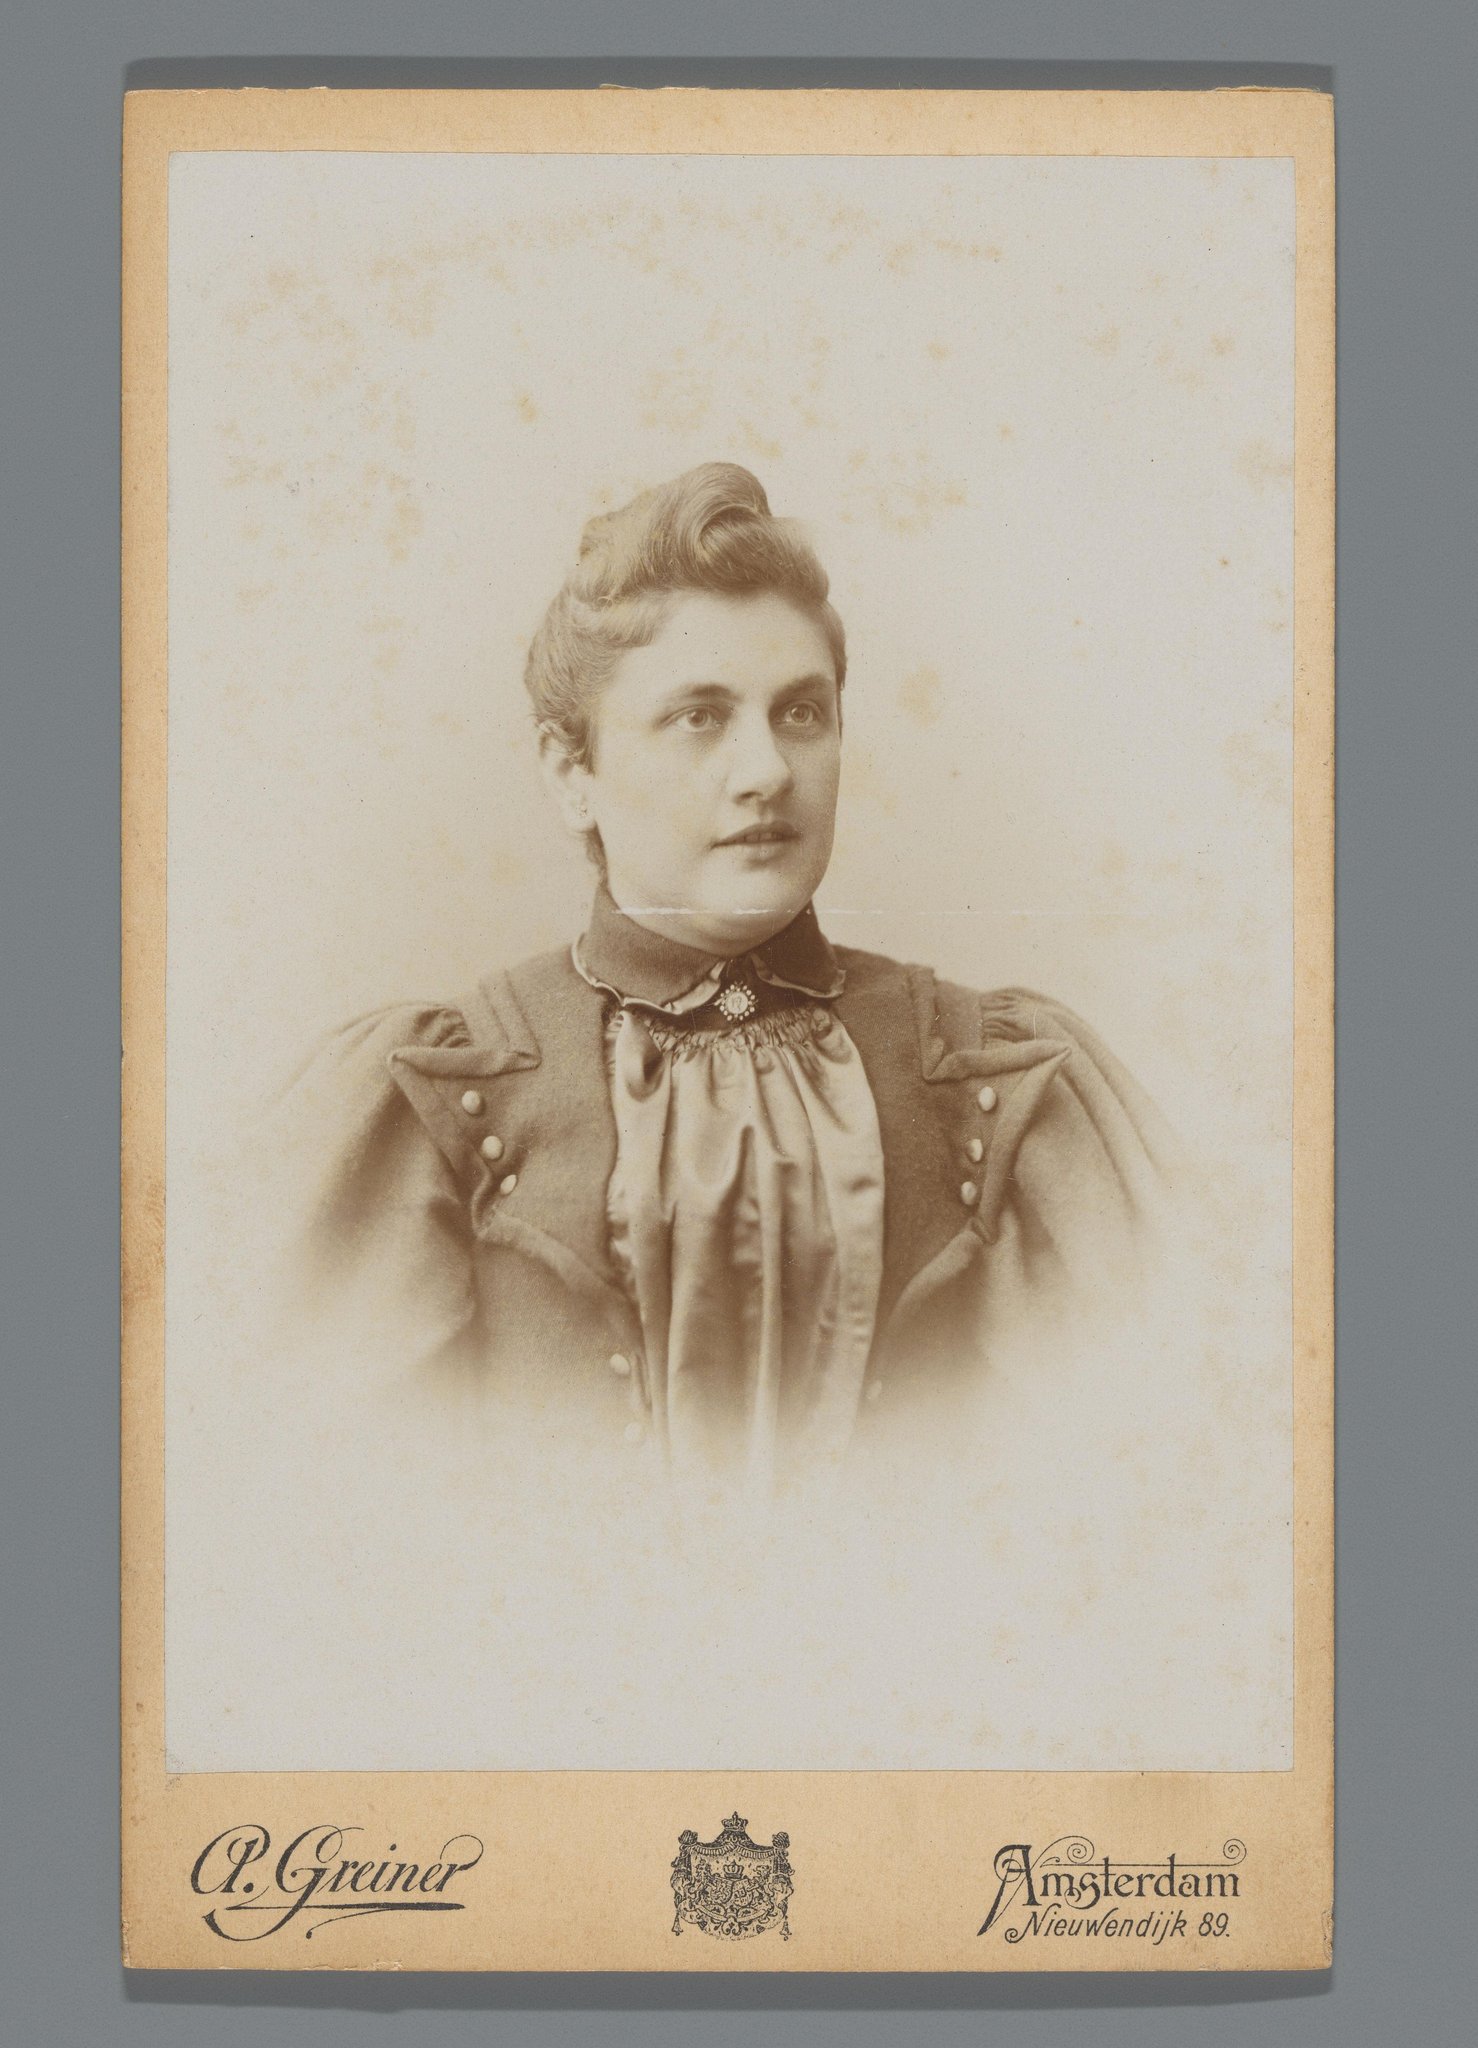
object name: cabinet photograph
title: Portret van een onbekende vrouw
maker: albert greiner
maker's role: fotograaf, fotostudio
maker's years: 1833-1890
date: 1883-1887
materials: cardboard, paper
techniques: gelatin silver print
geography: amsterdam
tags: anonymous historical person portrayed - bb - woman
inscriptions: address: ‘Amsterdam/ Nieuwendijk 89.’